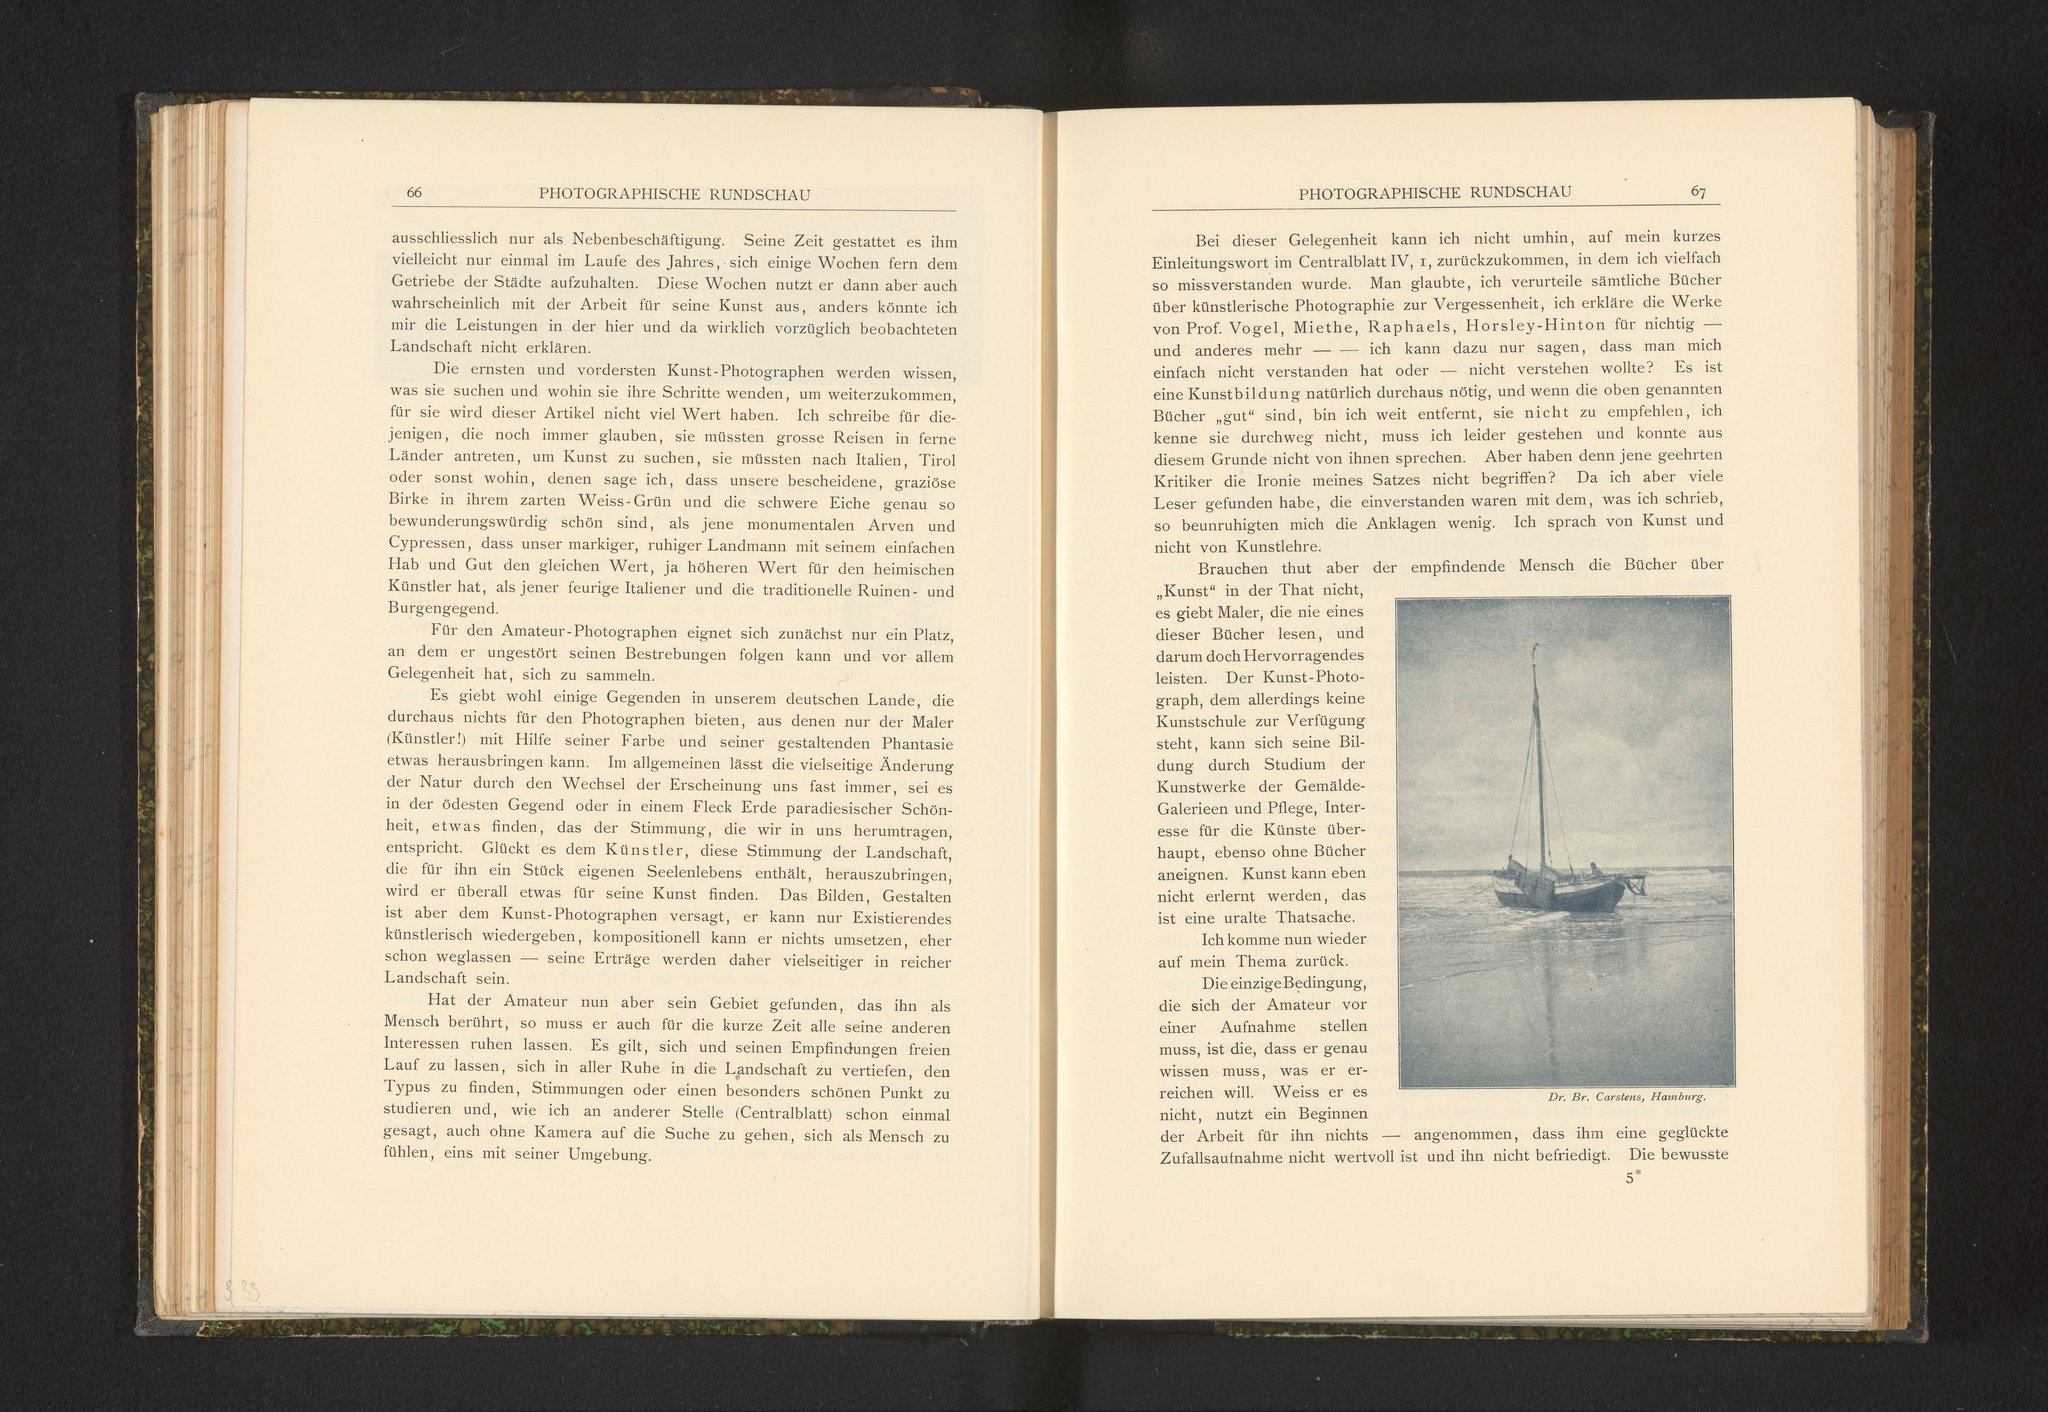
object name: photomechanical print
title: Zeilschip in de branding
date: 1893-1898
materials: paper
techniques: autotype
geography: hamburg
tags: sailing-ship, sailing-boat, beach